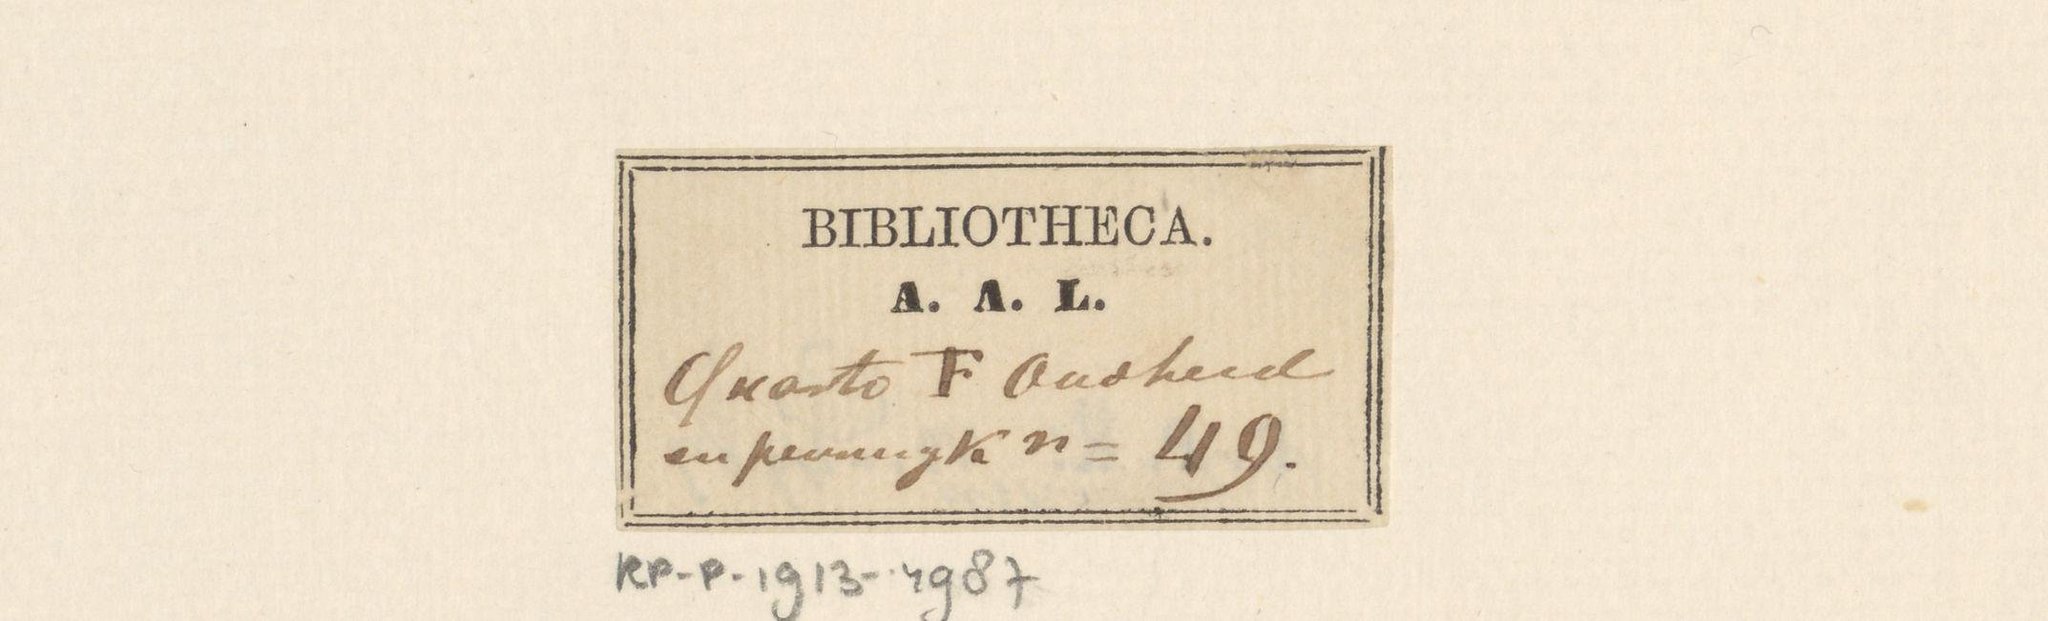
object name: bookplate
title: Ex libris van A.A.L.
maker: Anonymous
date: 1828-1893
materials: paper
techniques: printing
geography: netherlands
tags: numismaat, a.a. looyen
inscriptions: collector's mark: Lugt 2233, inscription: ‘Quarto F Oudheid / en penningKn = 49’, collector's mark: Lugt 2760